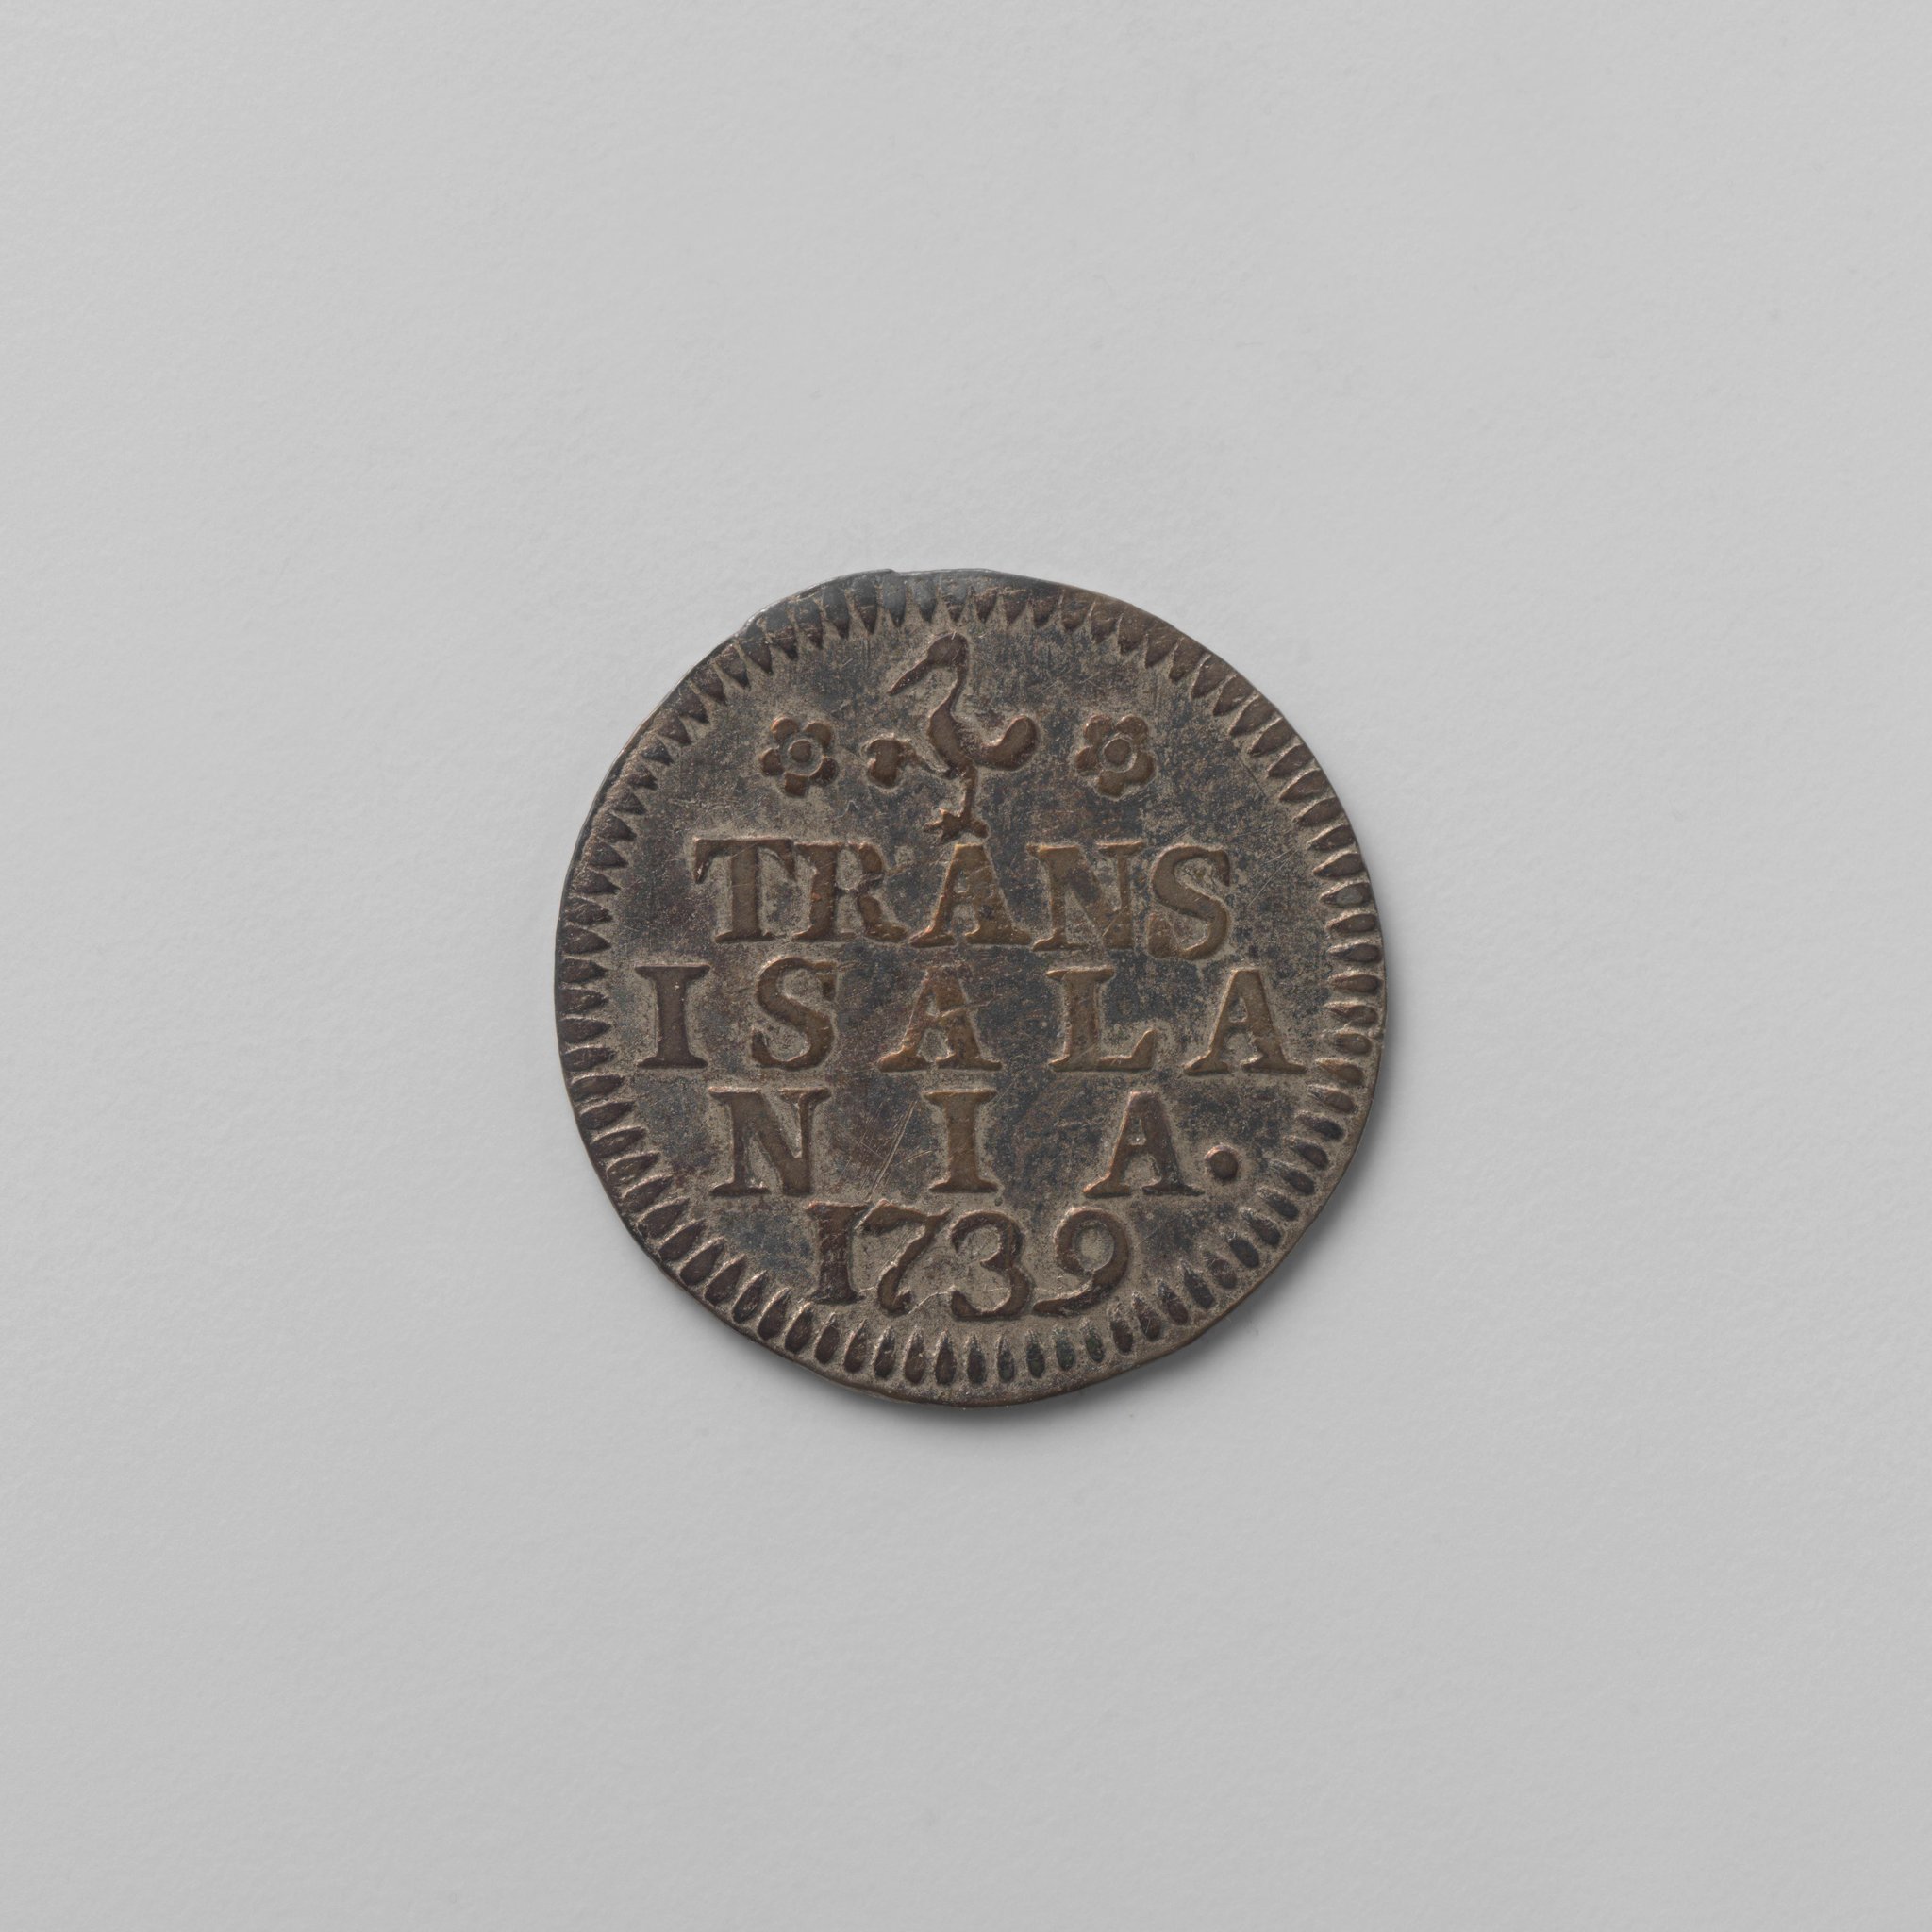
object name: coin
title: Overijssel, bezemstuiver, 1739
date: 1739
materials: silver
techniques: striking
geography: kampen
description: Zilveren munt. Voorzijde: drieregelig opschrift, waarboven muntmeesterteken en waaronder jaartal. Keerzijde: binnen lauwerkrans tussen waarde-aanduiding I S pijlenbundel. Gladde rand.